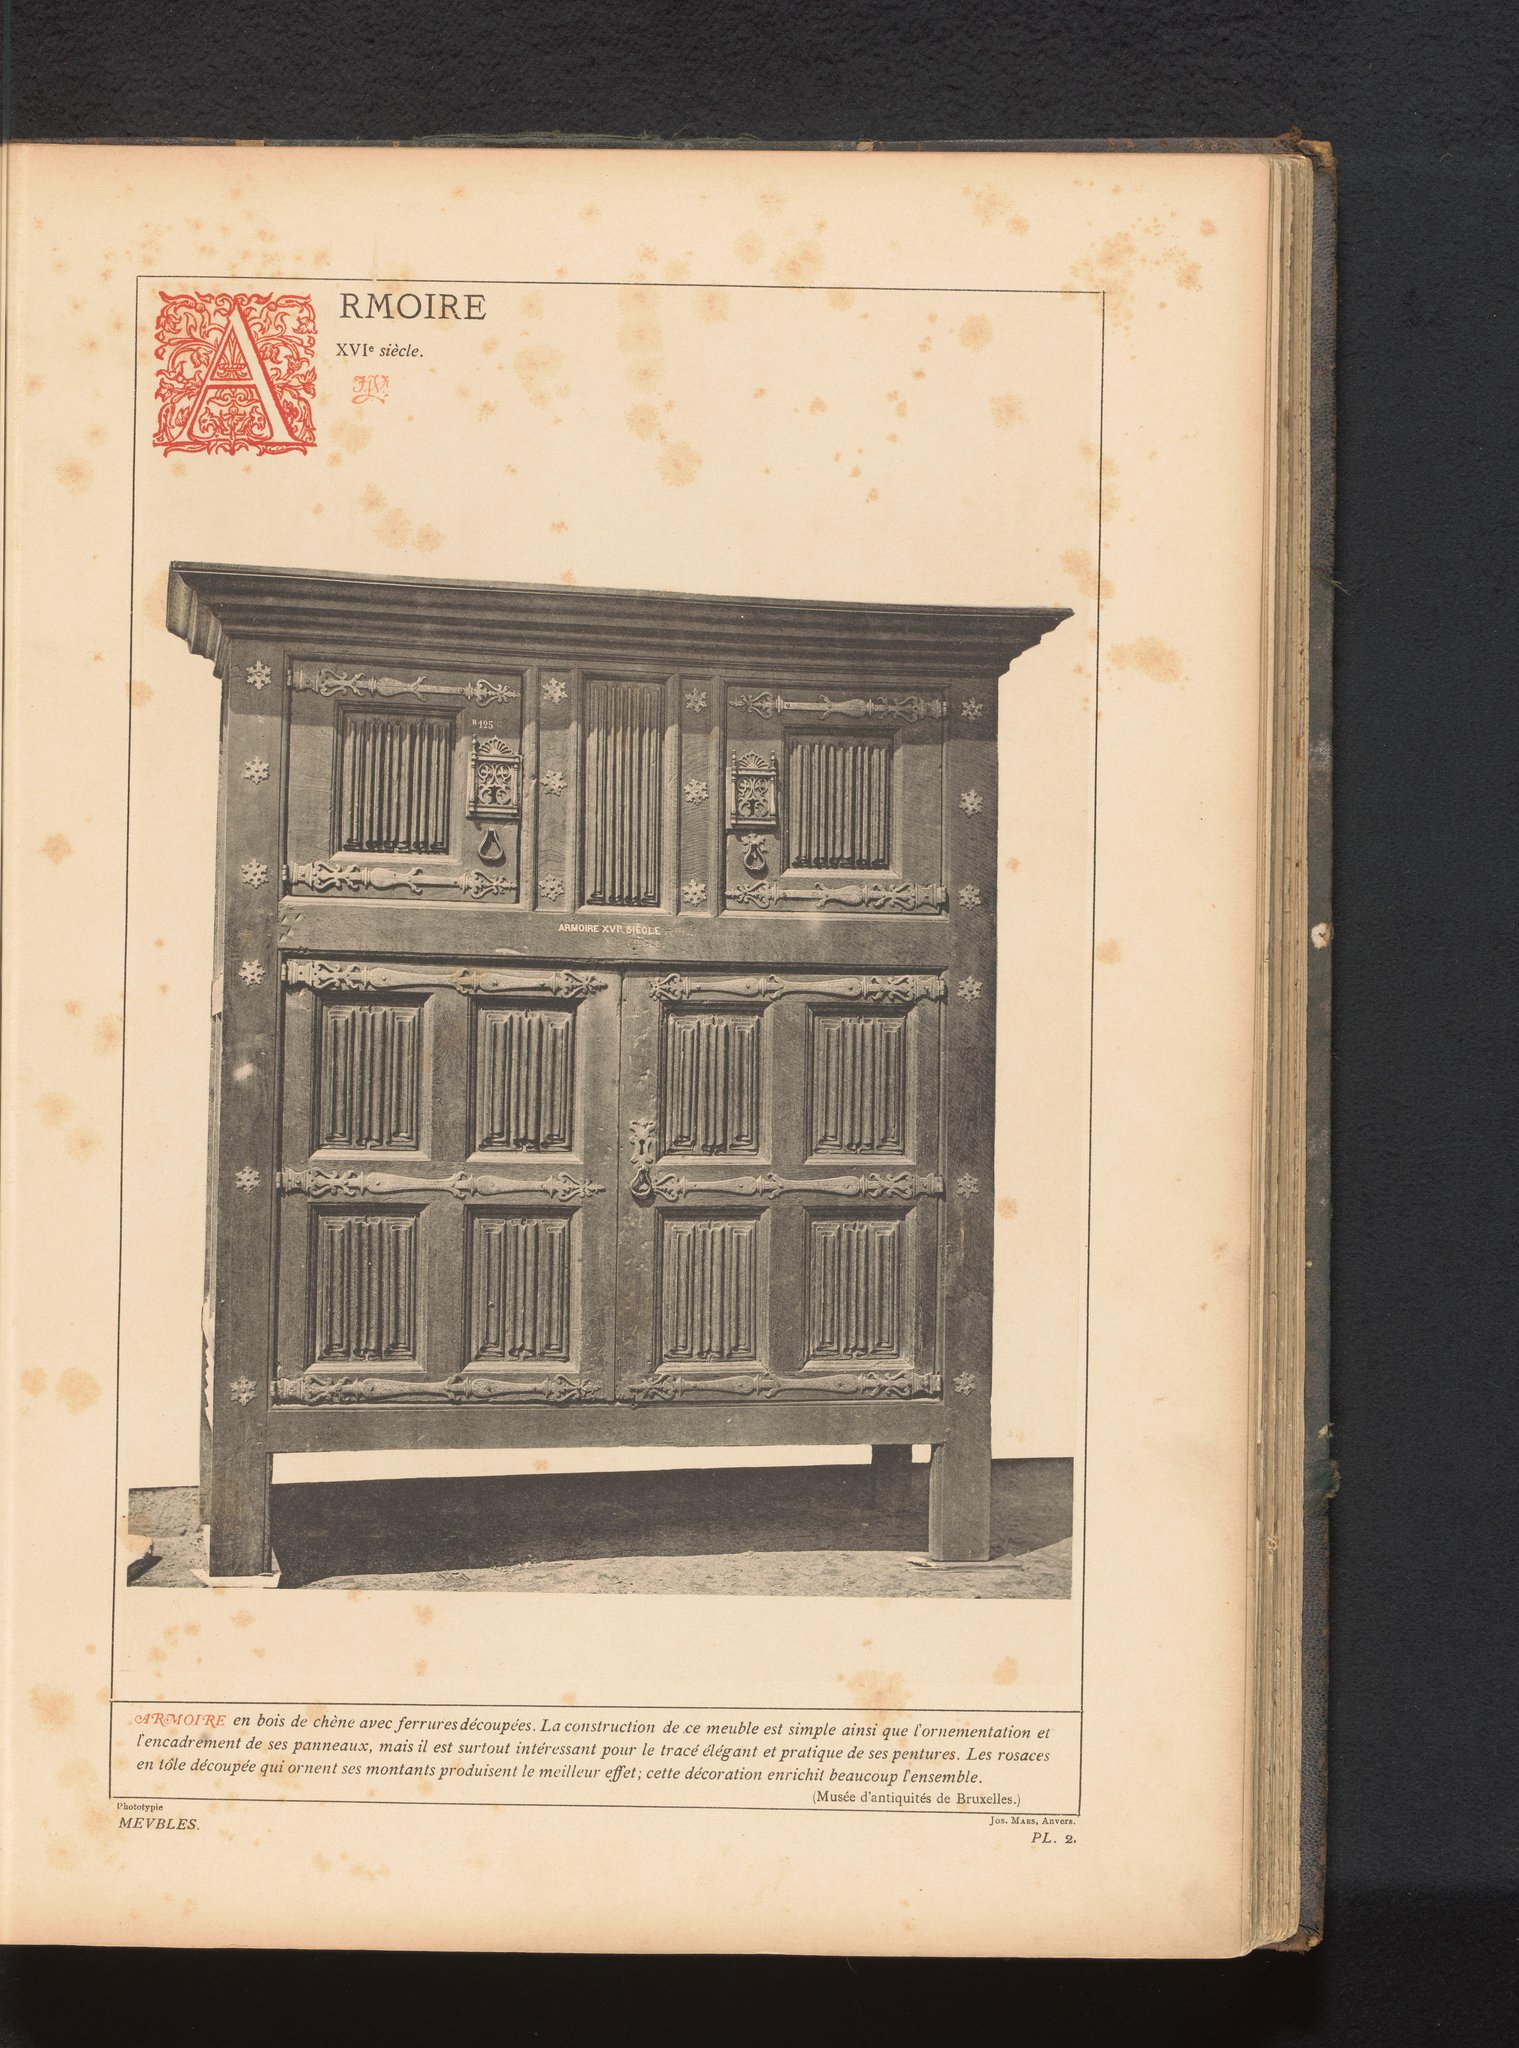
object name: photomechanical print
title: Gedecoreerde kast van eikenhout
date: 1882-1887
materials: paper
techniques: photograph, photolithography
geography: antwerp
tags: ornamental cupboard (+ wood and other phytogenic material)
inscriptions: inscription: ‘MEUBLES. - PL. 2.’, inscription: ‘ARMOIRE en bois (...)’, monogram: ‘JJvY’